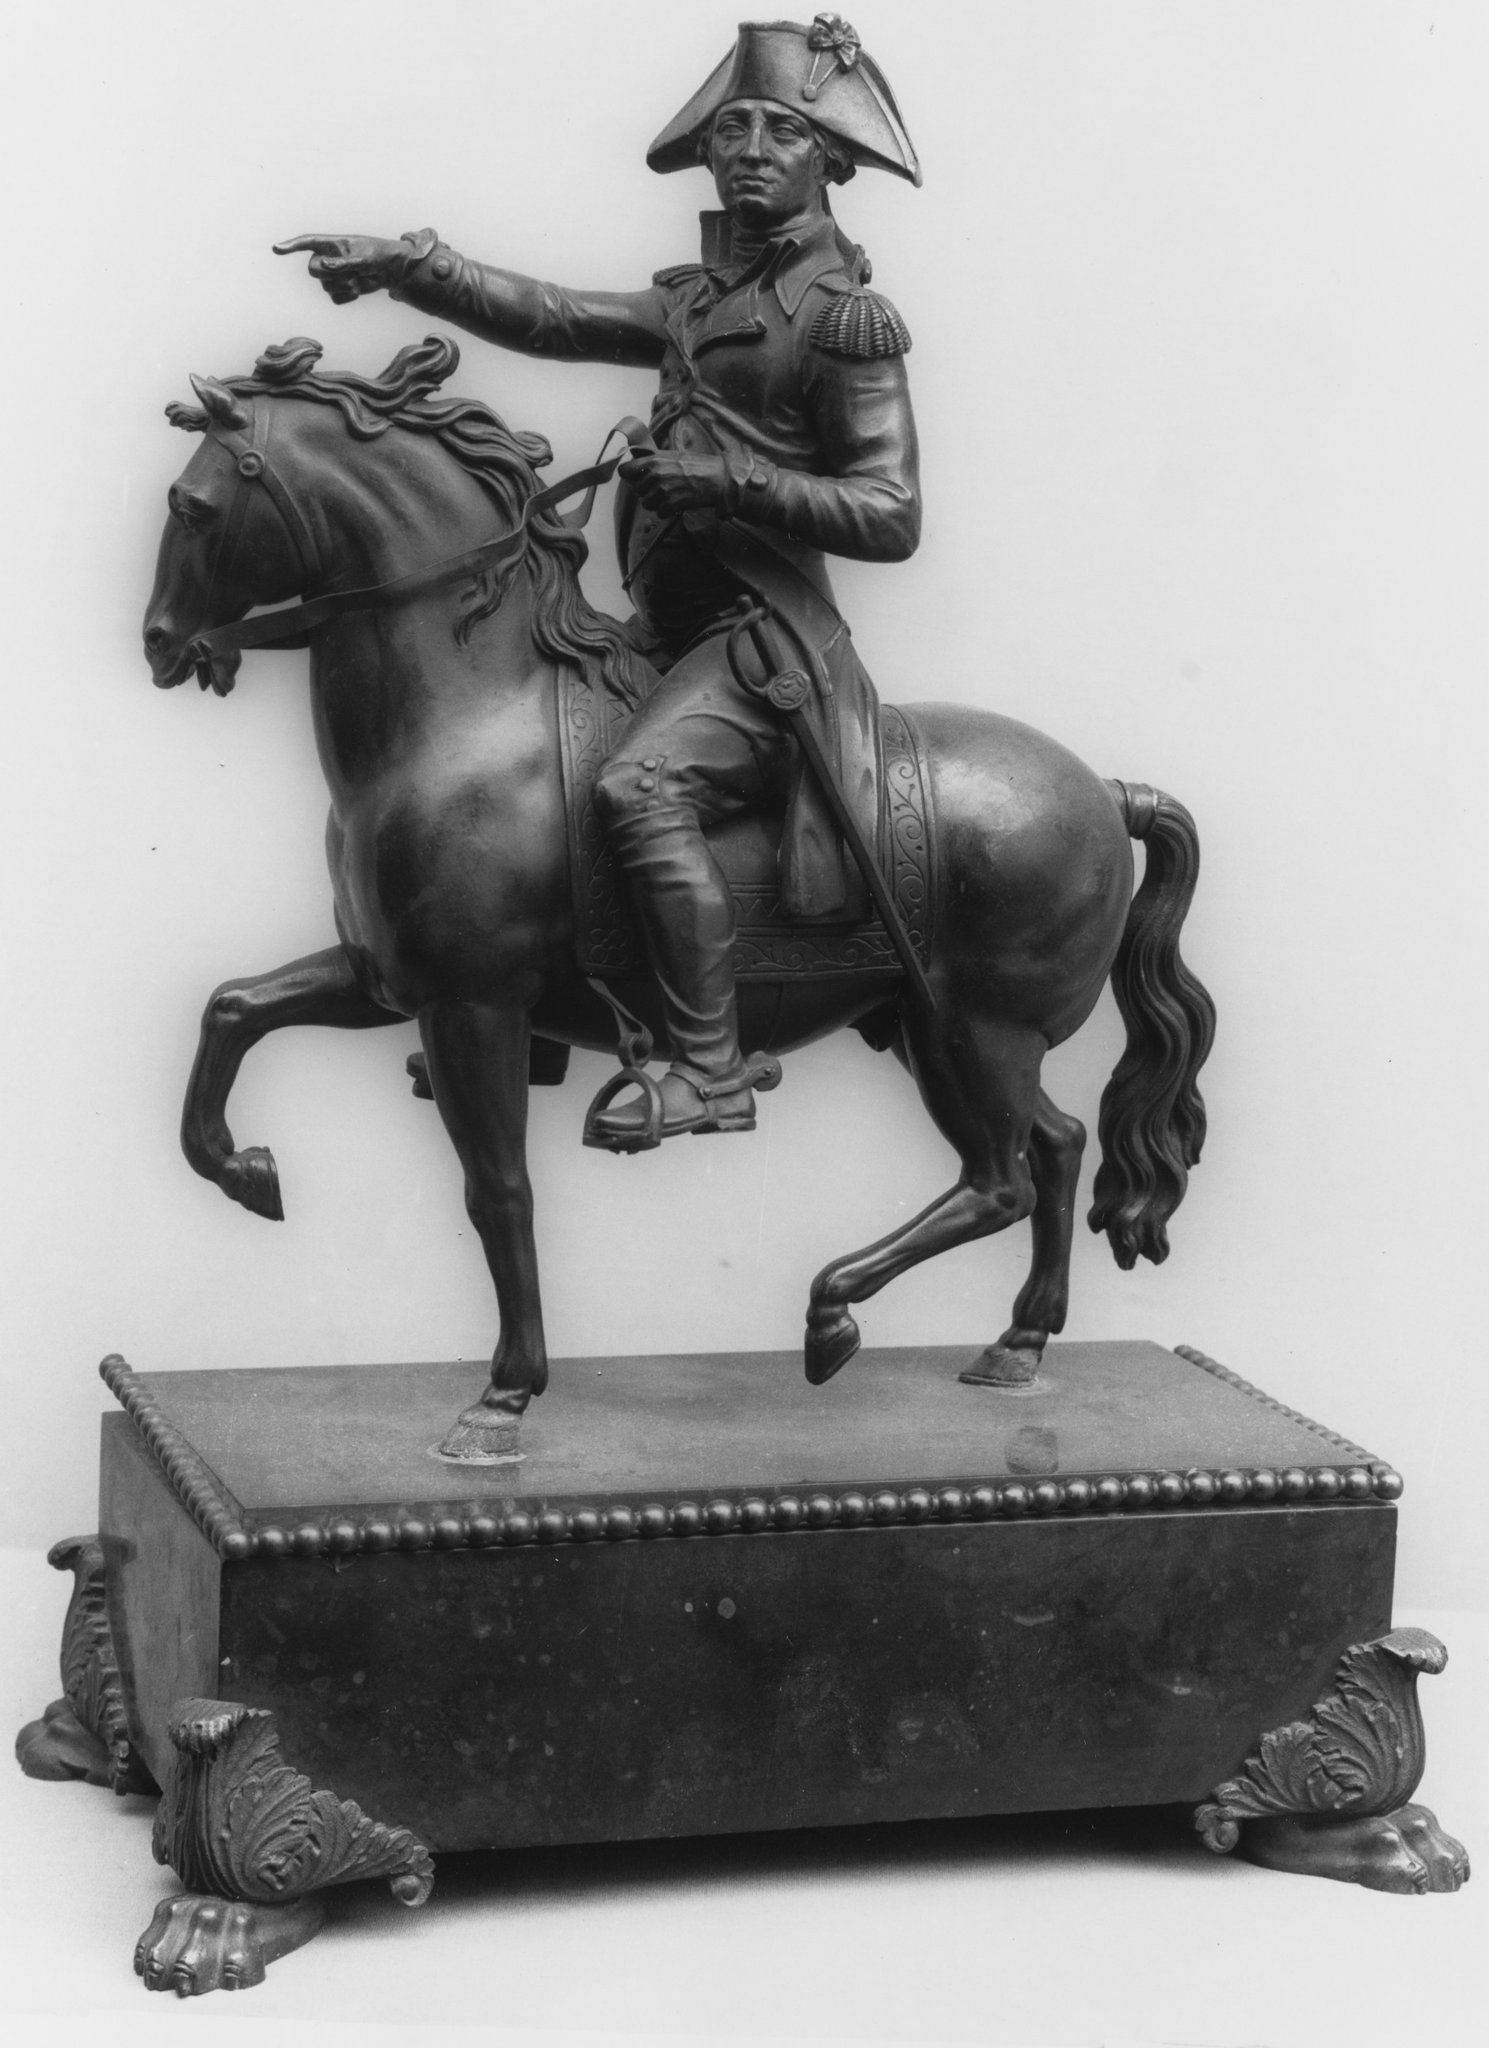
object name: statuette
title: George Washington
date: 1850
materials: bronze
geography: france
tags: george washington,men,horses